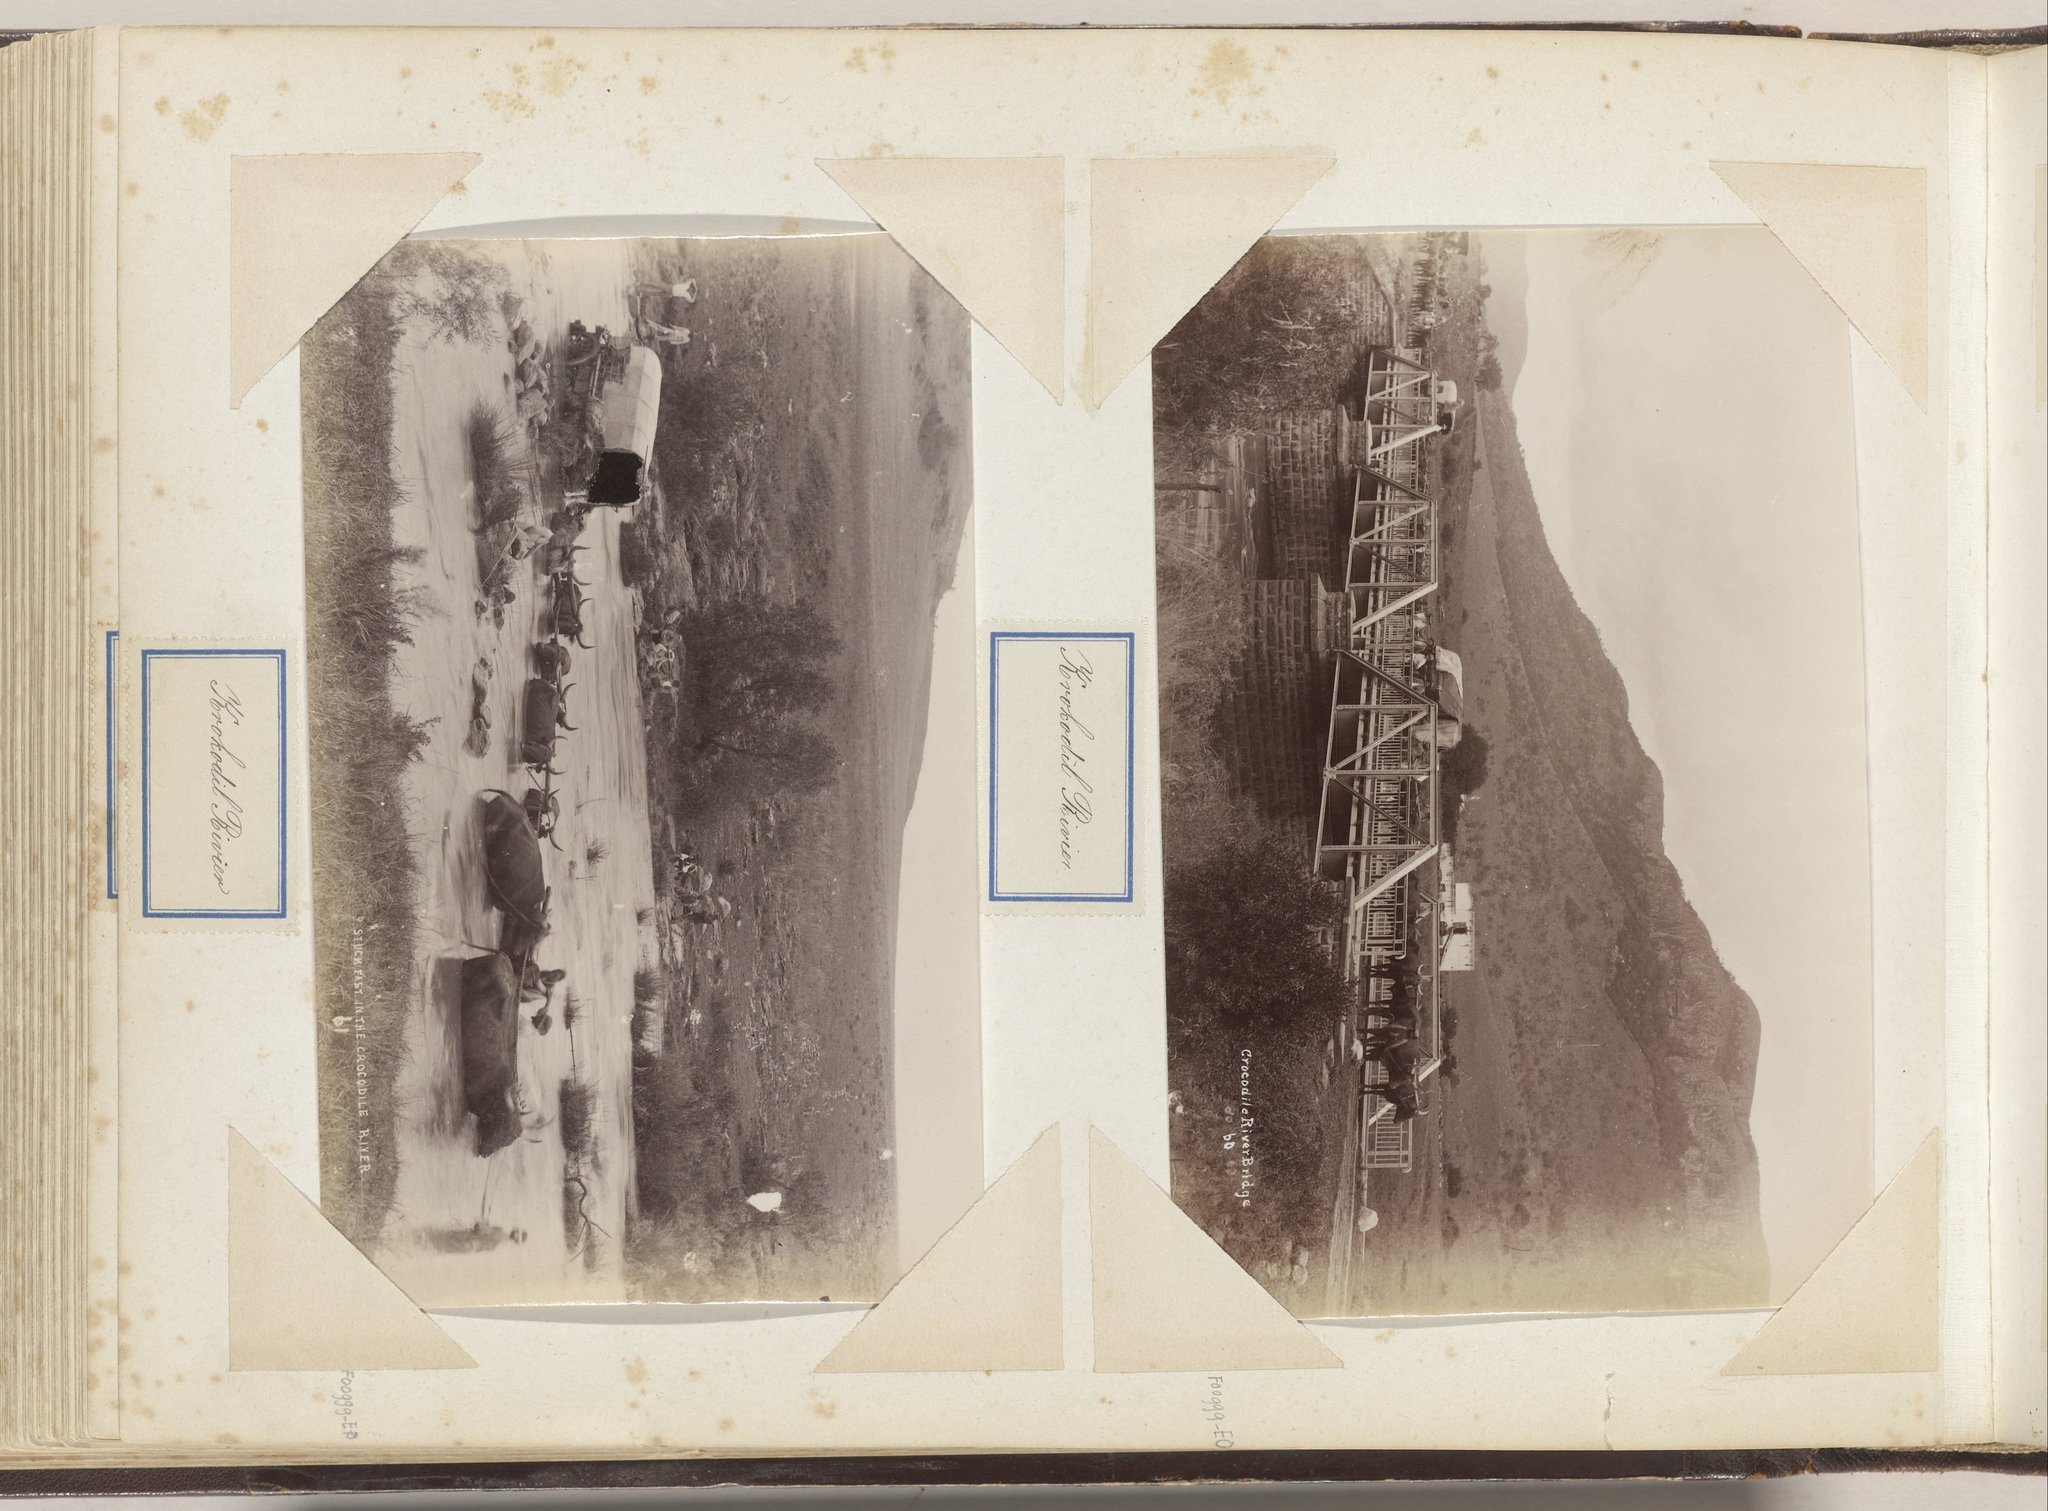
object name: photograph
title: Krokodil Rivier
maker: Anonymous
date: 1896-1910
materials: paper, photographic support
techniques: albumen print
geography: south africa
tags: bridge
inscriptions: negative number: ‘60’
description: Onderdeel van Album met 191 foto's van een reis naar en door Zuid-Afrika.